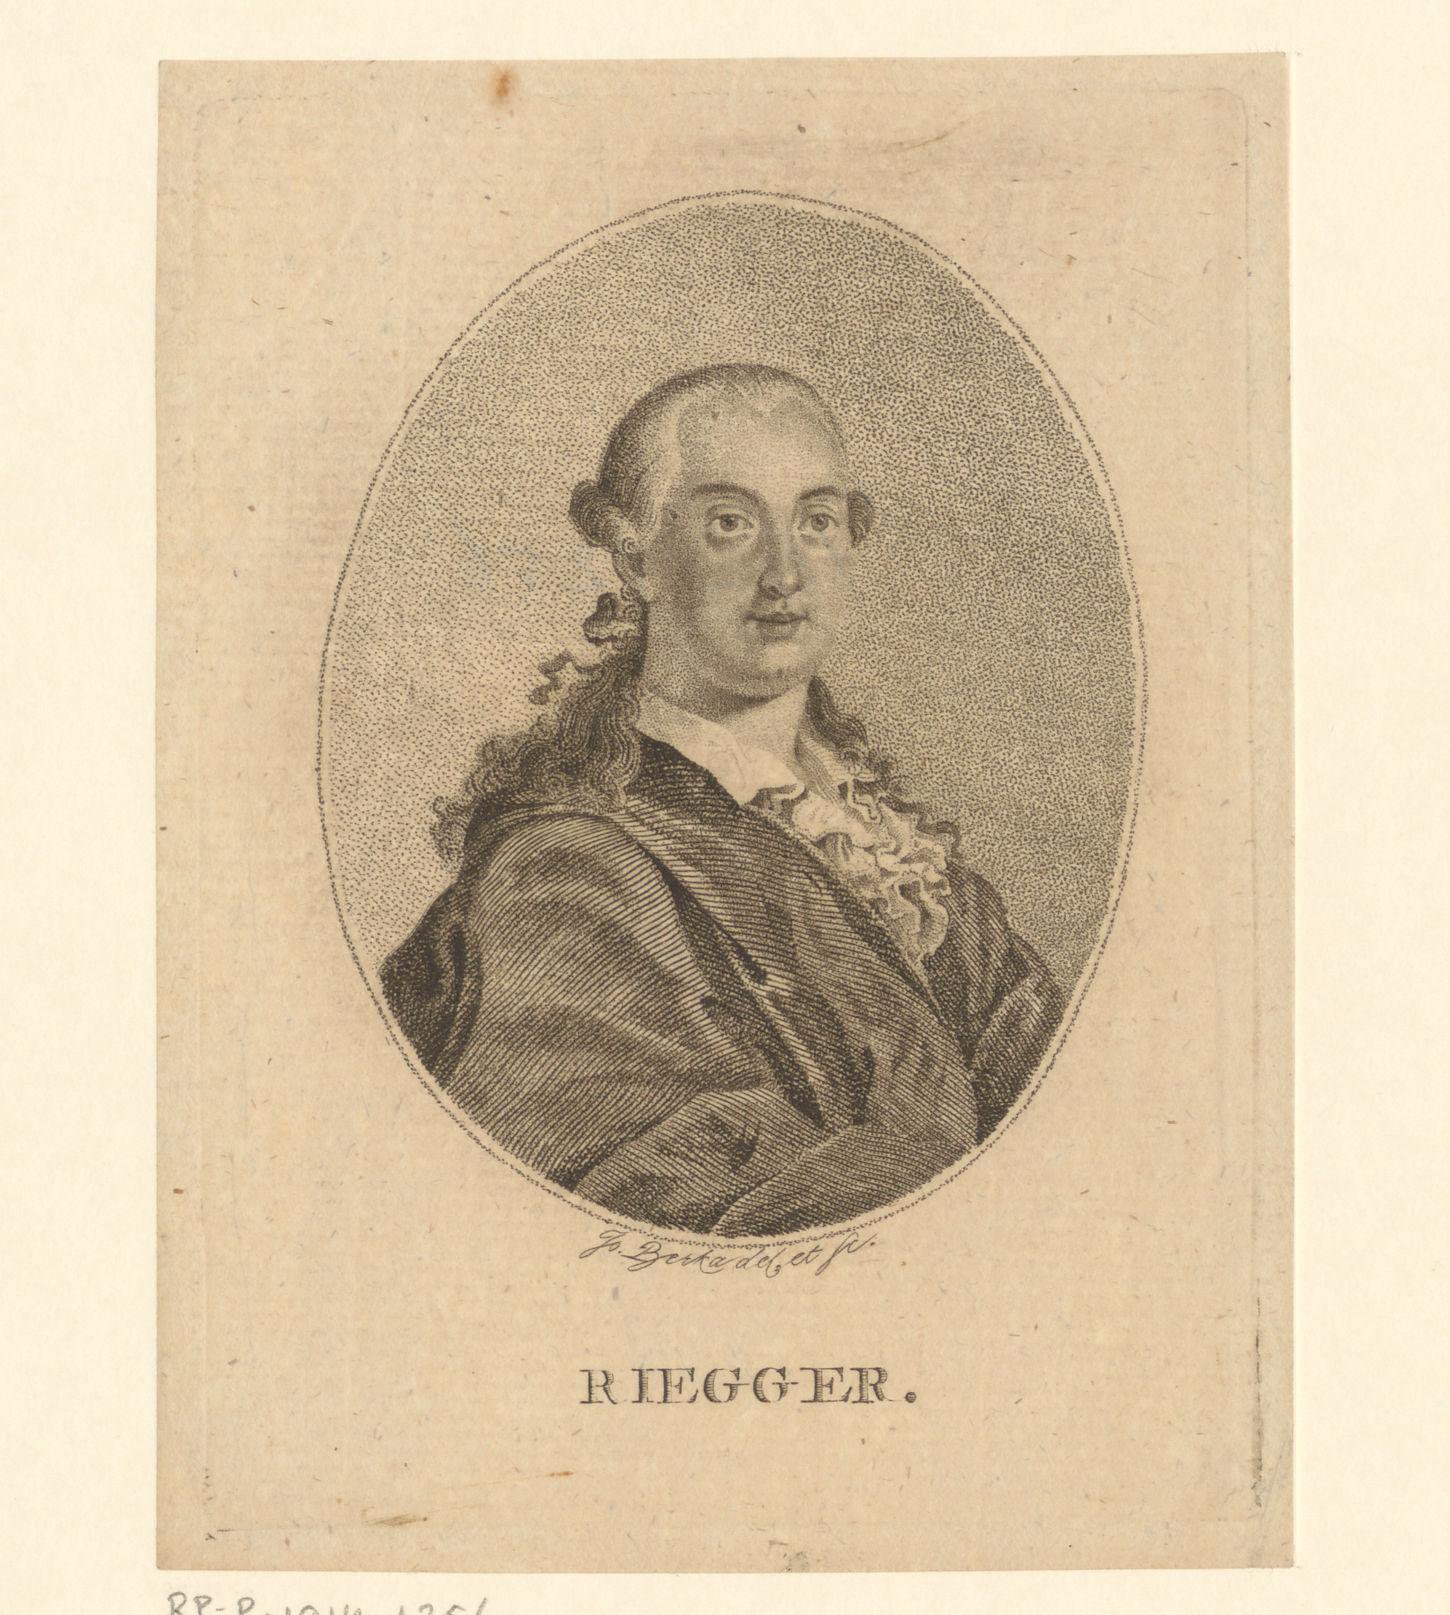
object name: print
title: Portret van Joseph Anton Stephan Riegger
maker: johann berka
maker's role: painter, print maker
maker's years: 1759-1838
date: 1794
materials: paper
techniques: etching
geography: prague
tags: prague, historical persons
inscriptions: collector's mark: Lugt 2228